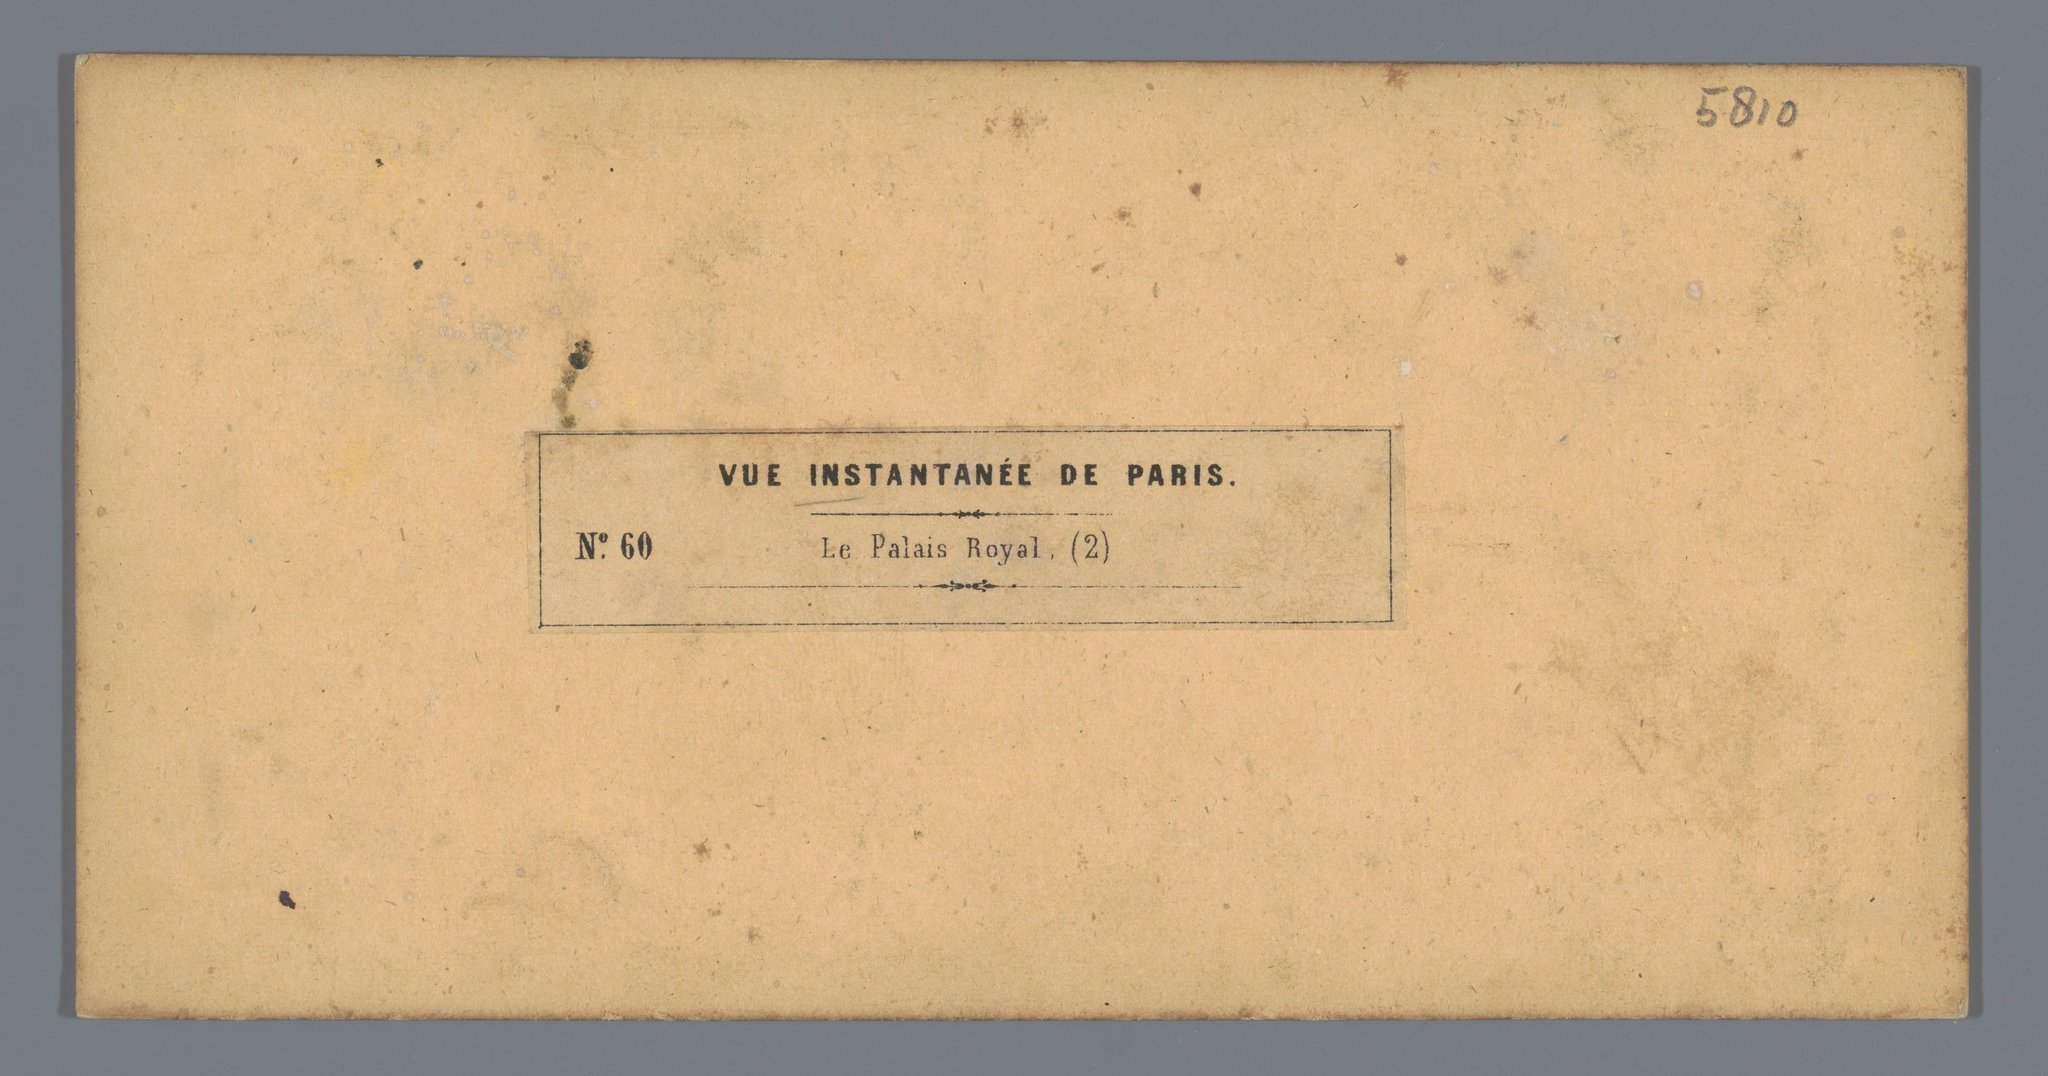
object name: stereograph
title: Gezicht op de Rue Saint-Honoré en het Palais-Royal in Parijs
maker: Anonymous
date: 1850-1880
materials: cardboard, photographic support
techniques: albumen print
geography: paris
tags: palace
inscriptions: number: ‘No. 60’